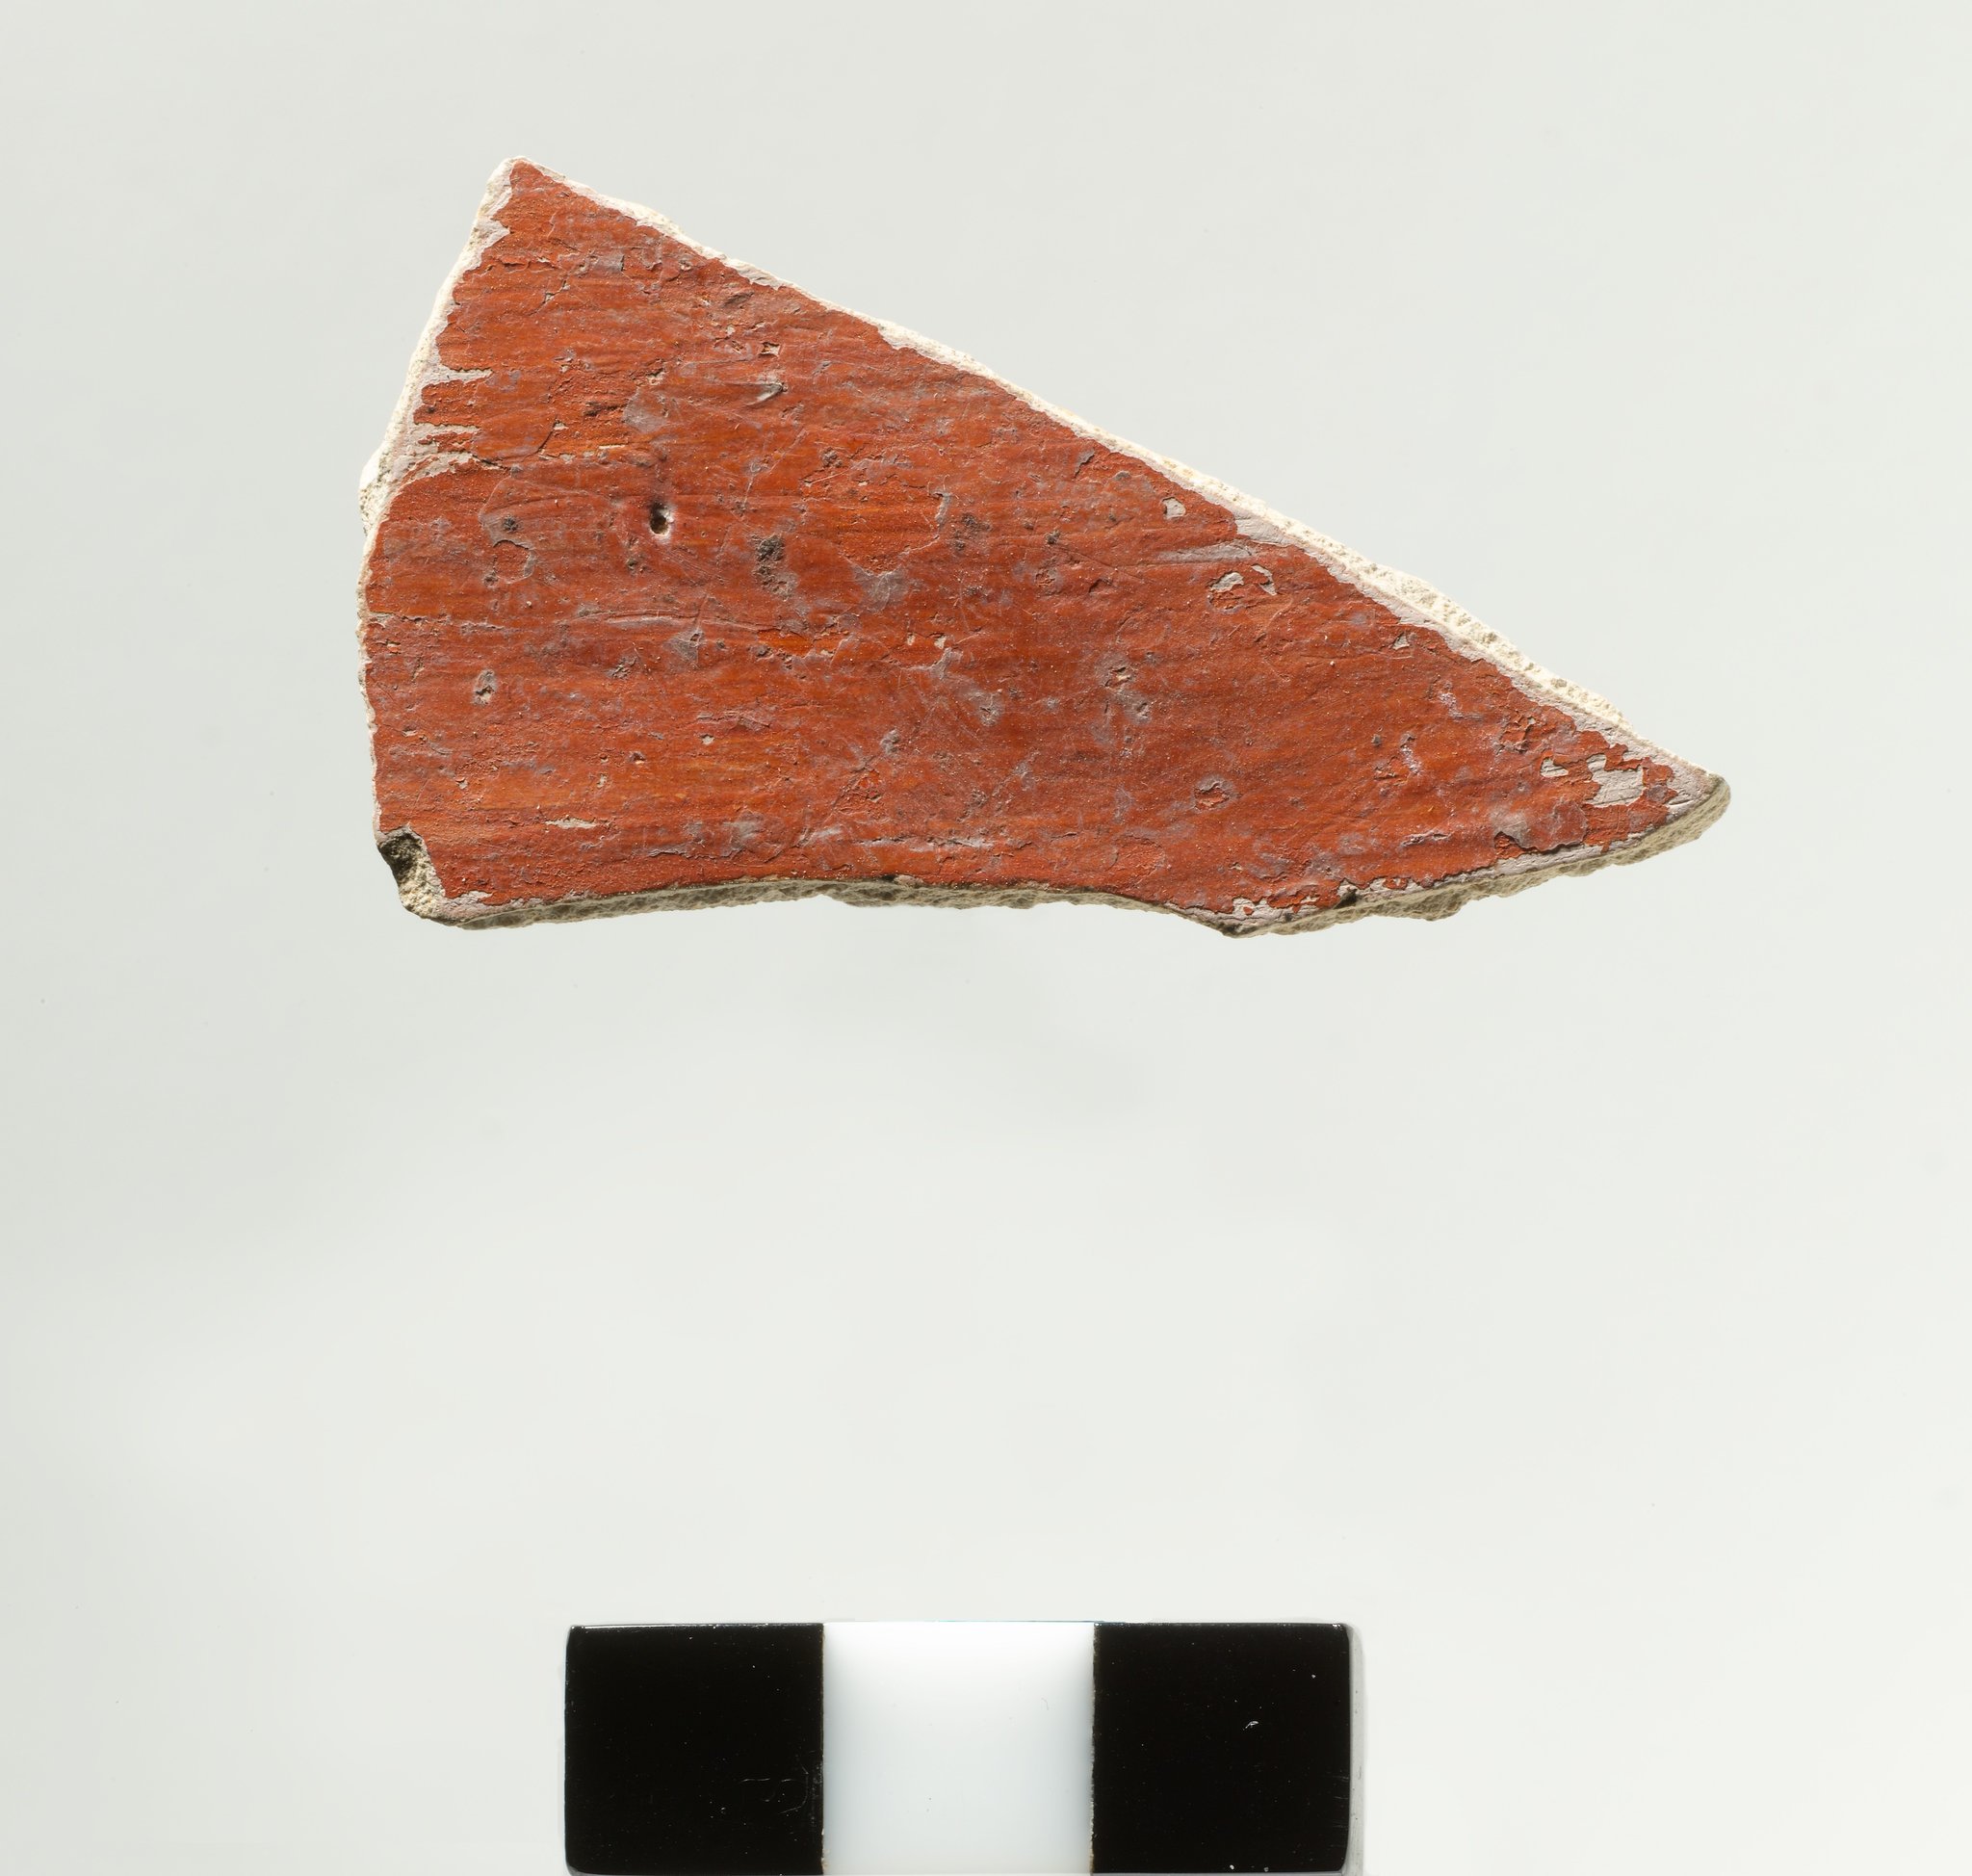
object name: relief fragment, tomb of meketre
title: Reliefs from the tomb of Meketre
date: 1981-1975 BCE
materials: limestone, paint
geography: egypt